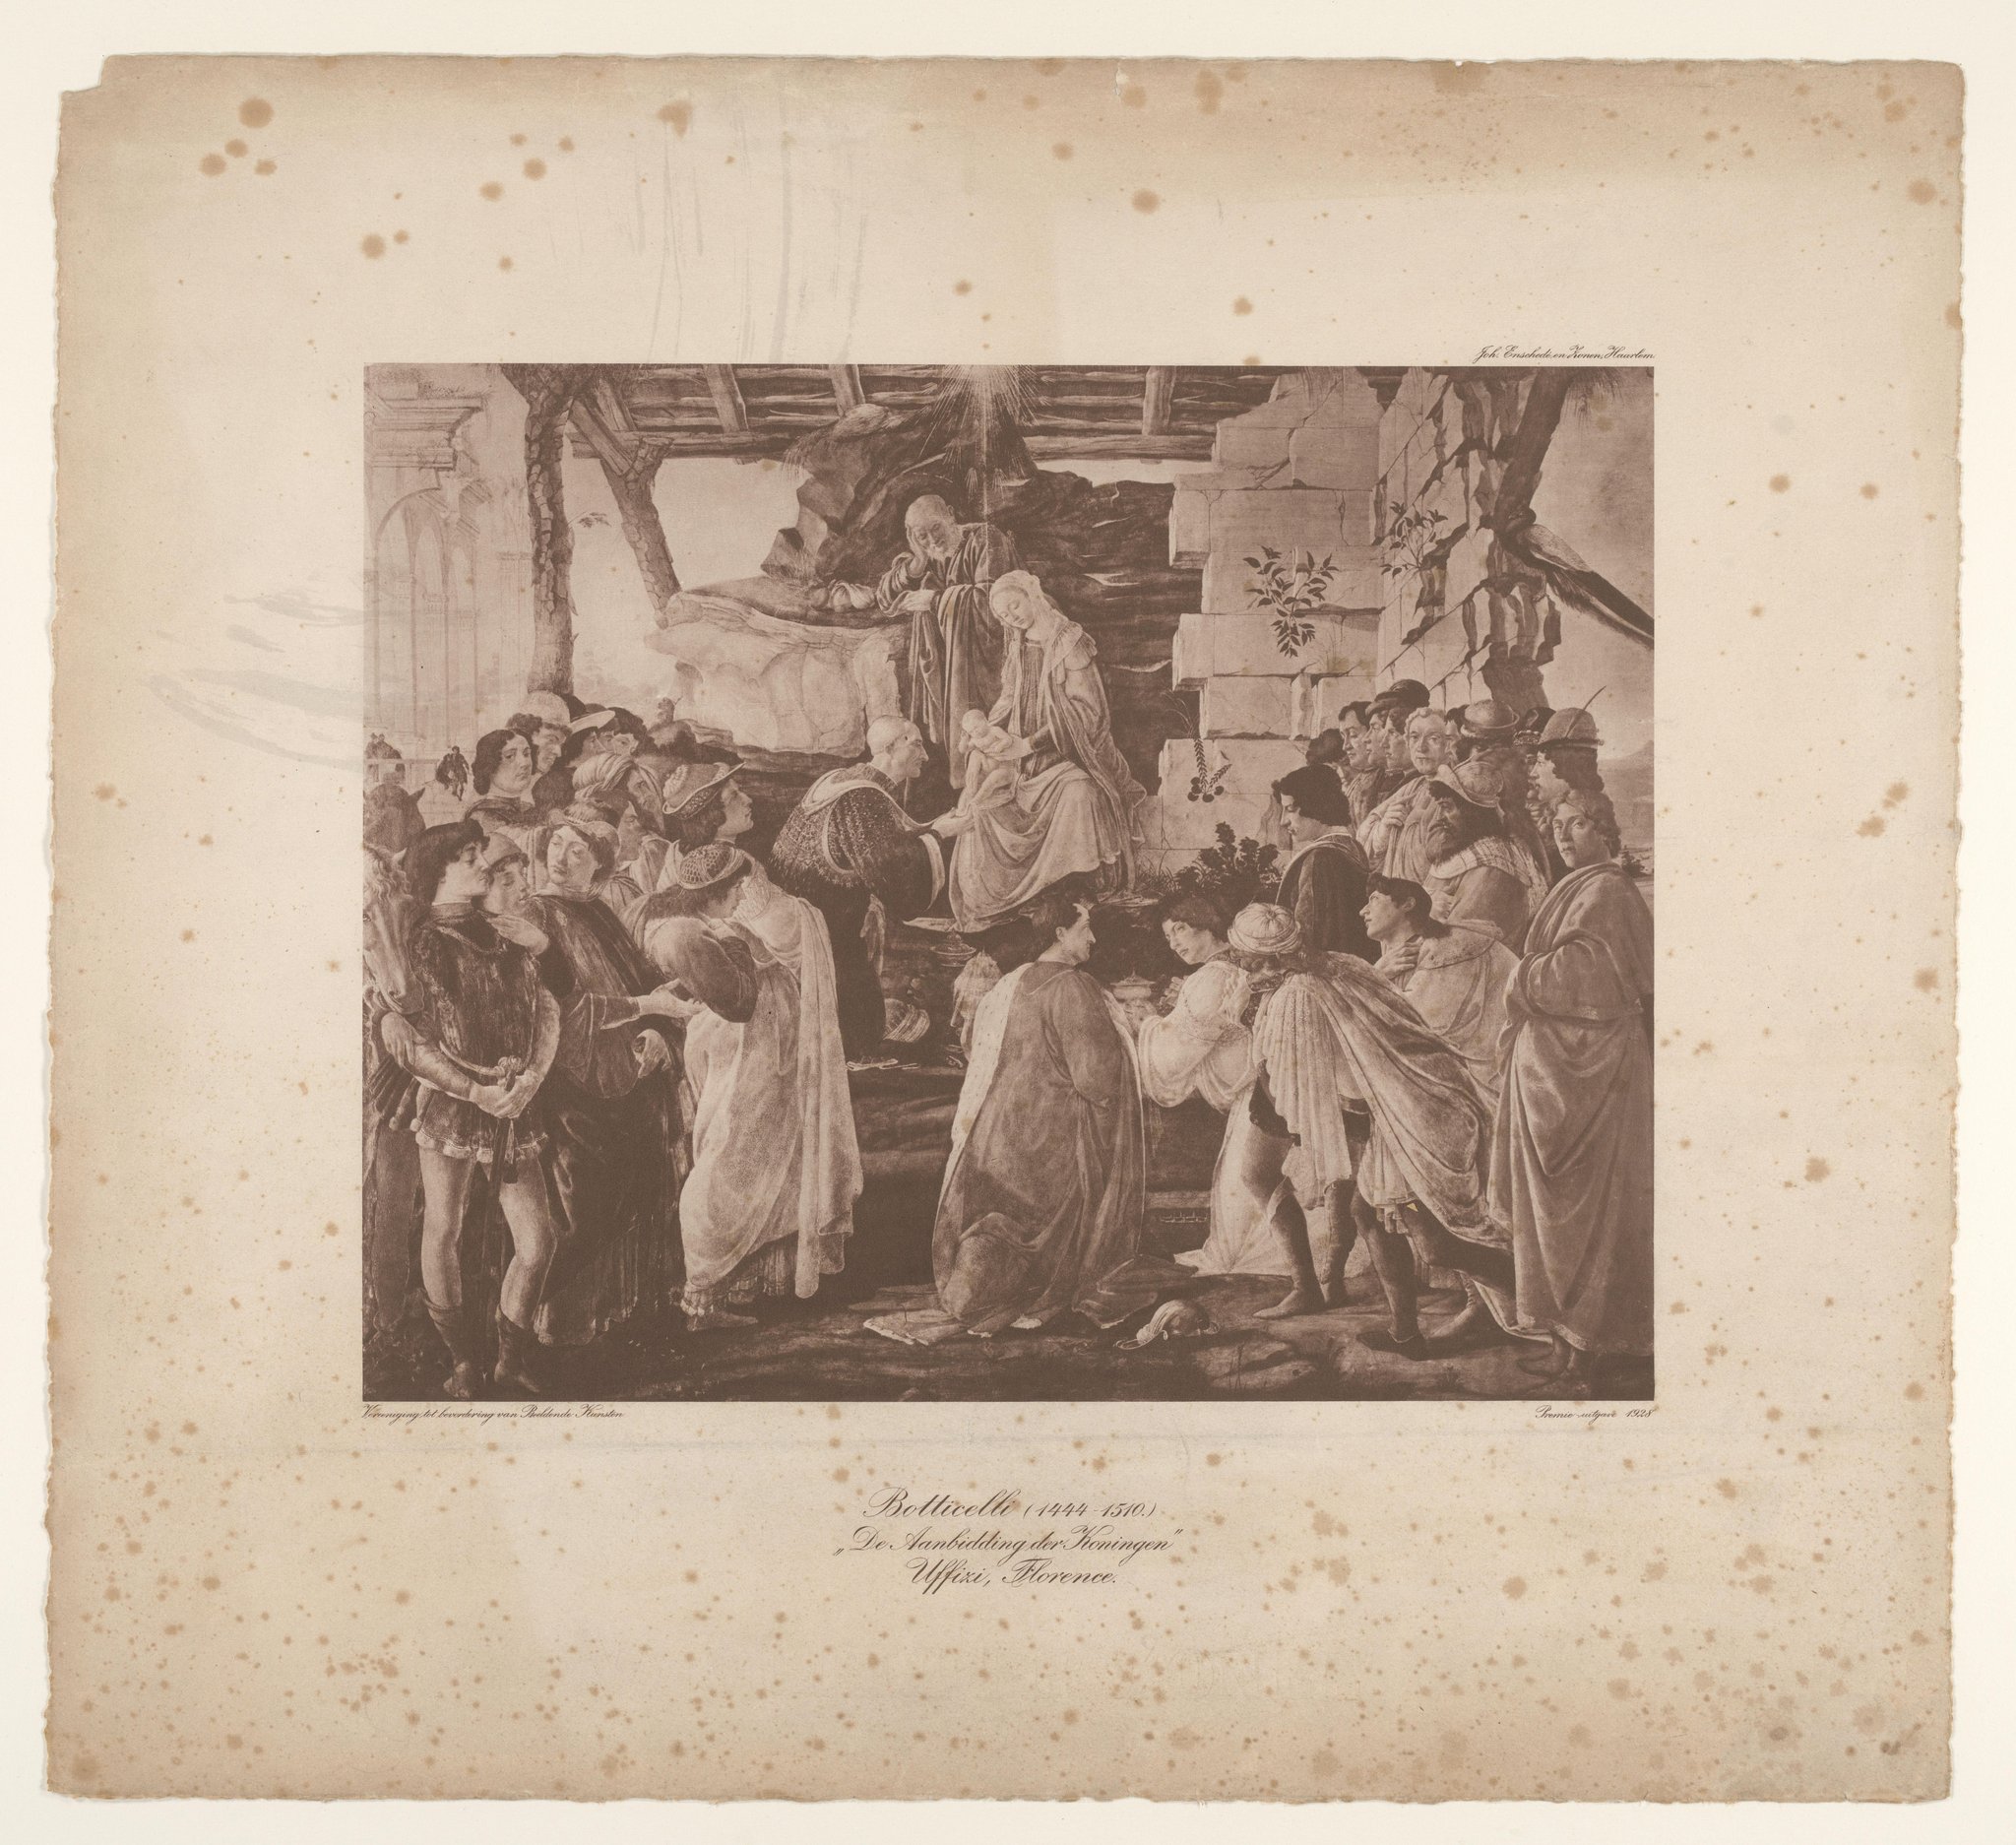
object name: reproduction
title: Fotoreproductie van het schilderij De aanbidding der koningen door Boticelli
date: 1928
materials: paper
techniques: rotogravure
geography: netherlands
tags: adoration of the kings: the wise men present their gifts to the christ-child (gold, frankincense and myrrh)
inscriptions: check stamp: ‘Gelder Zonen’, inscription: ‘Premie-uitgave 1928’